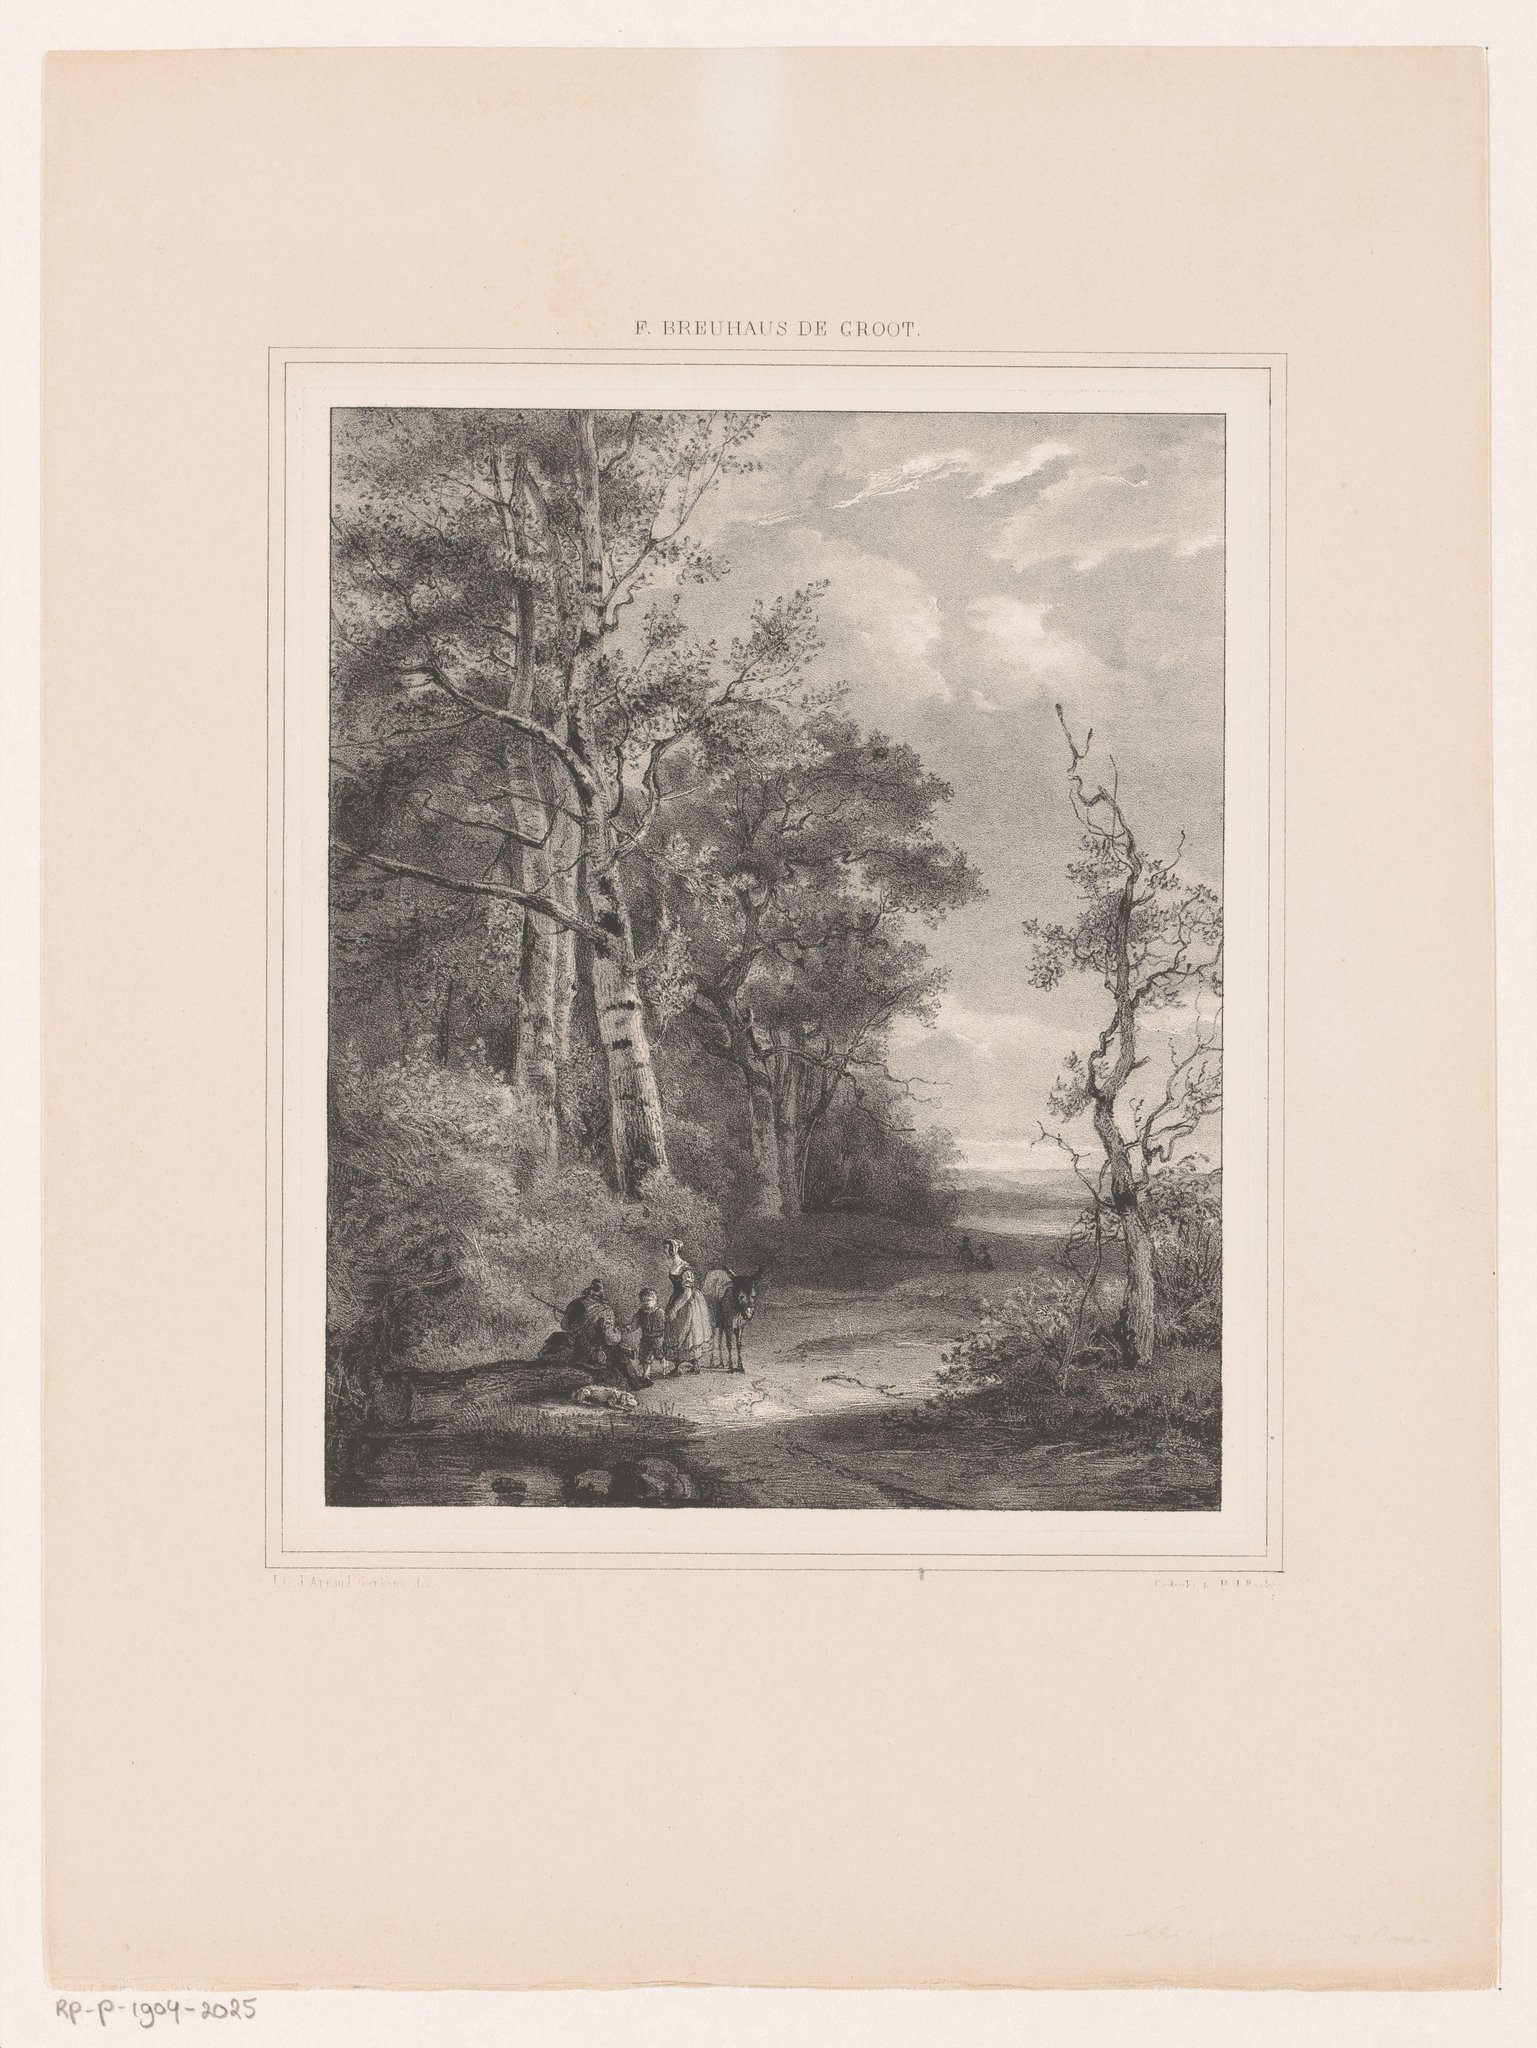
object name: print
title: Rustend gezelschap bij bosrand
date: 1822-1845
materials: paper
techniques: lithograph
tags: ass, donkey, hunters resting during the hunt, forest path or lane (+ landscape with figures, staffage)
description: Een landweg loopt langs het bos. Een jager zit op een boomstronk met zijn geweer op schoot. Bij hem staan een vrouw, kind en ezel.